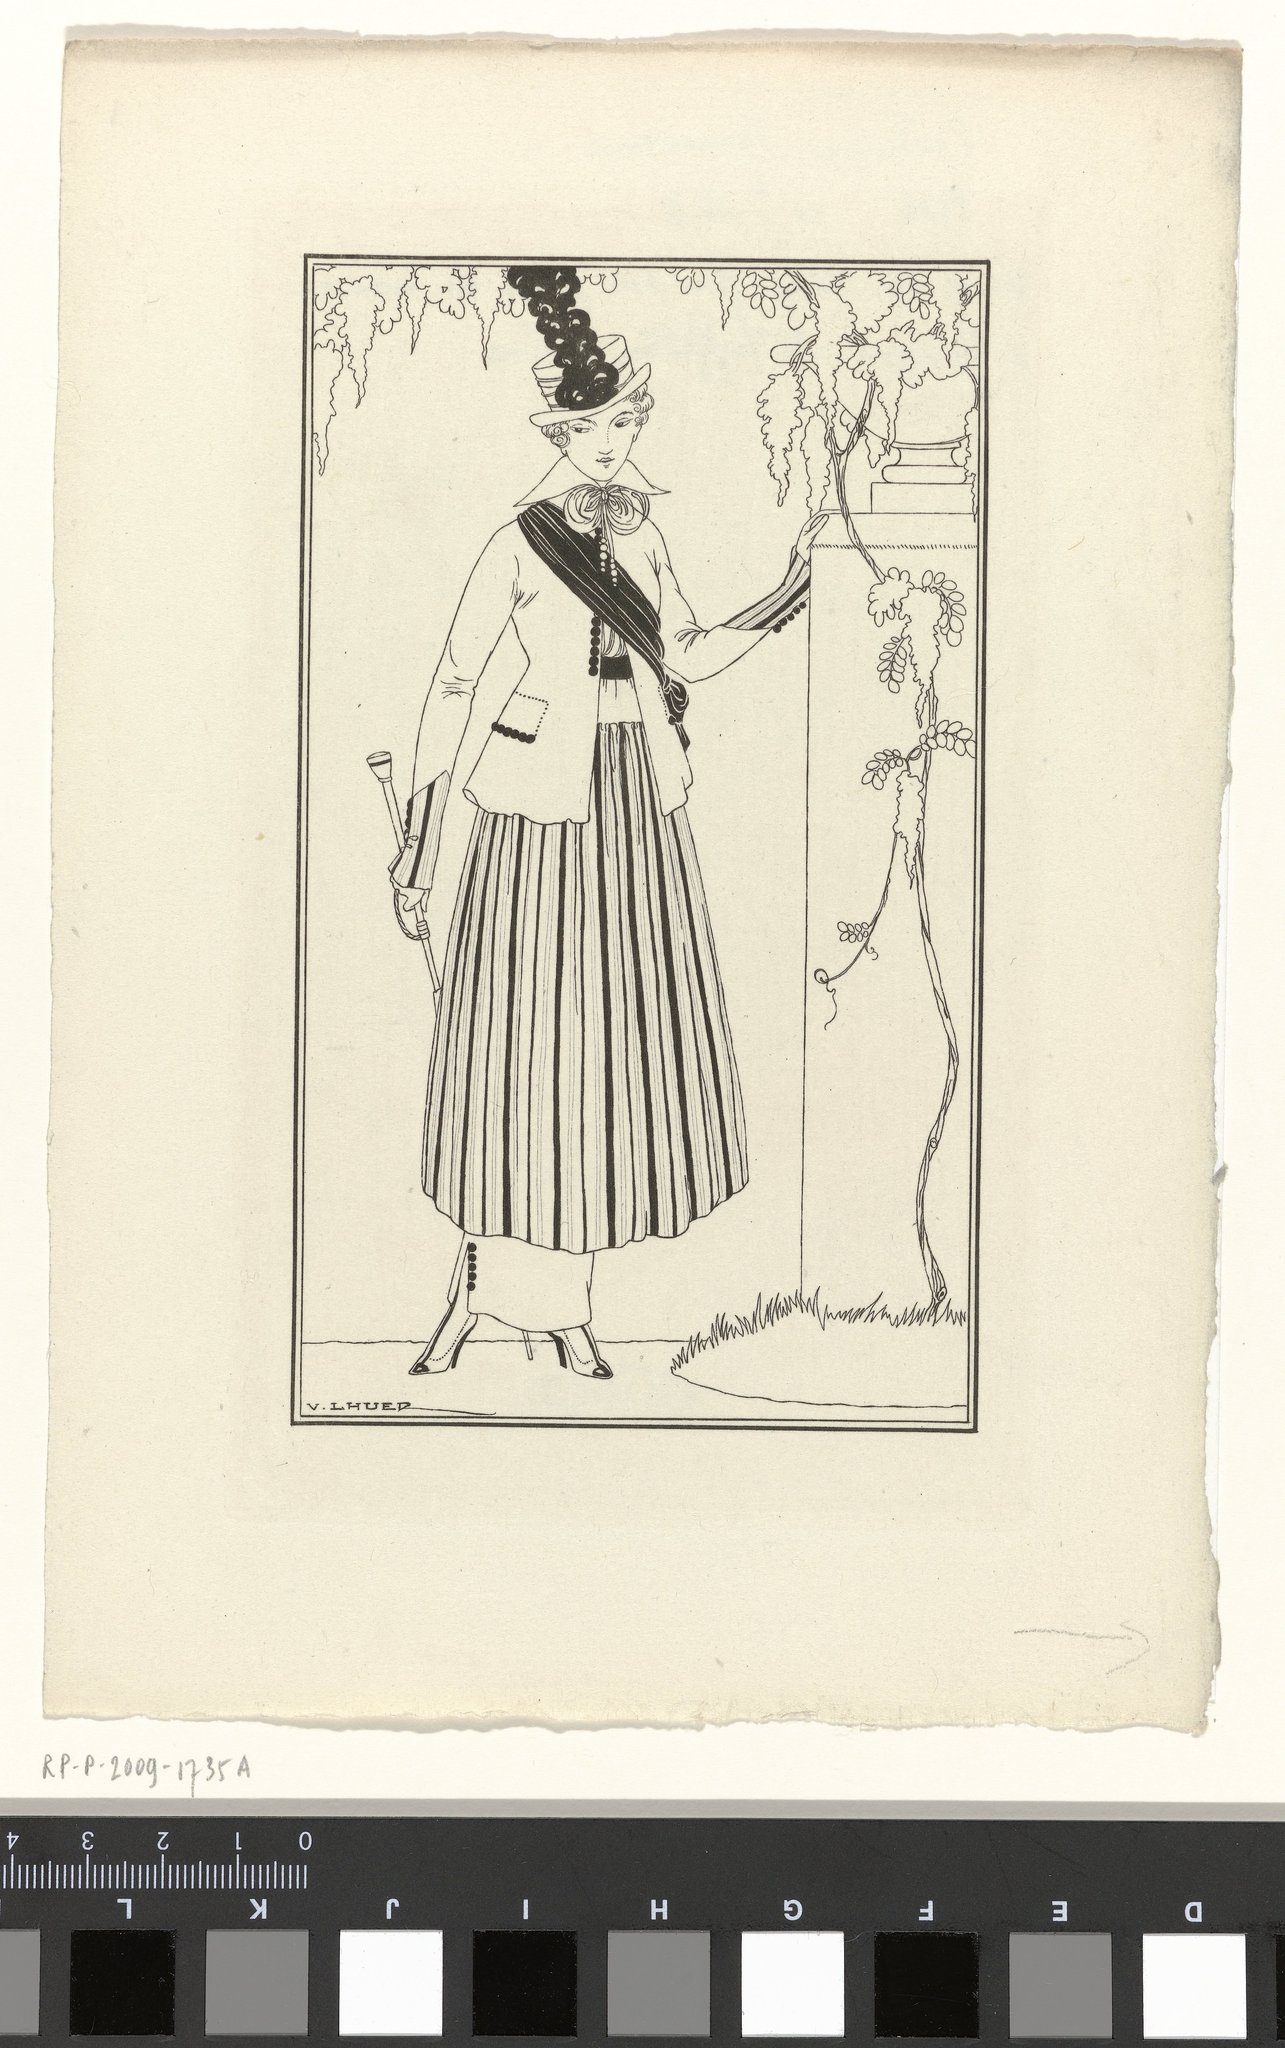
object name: fashion print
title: Journal des Dames et des Modes, Costumes Parisiens, 1914, No. 163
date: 1914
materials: paper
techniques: engraving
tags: walking-stick, staff, cane (+ women's clothes), coat (+ women's clothes), dress, gown (tunic) (+ women's clothes), fashion plates, head-gear: hat (+ women's clothes), skirt (+ women's clothes)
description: Jasje van fijn laken op eenzelfde rok. Tuniek van tafzijde of 'taffetas pékiné'. Proefdruk van een prent uit het modetijdschrift Journal des Dames et des Modes (1912-1914).